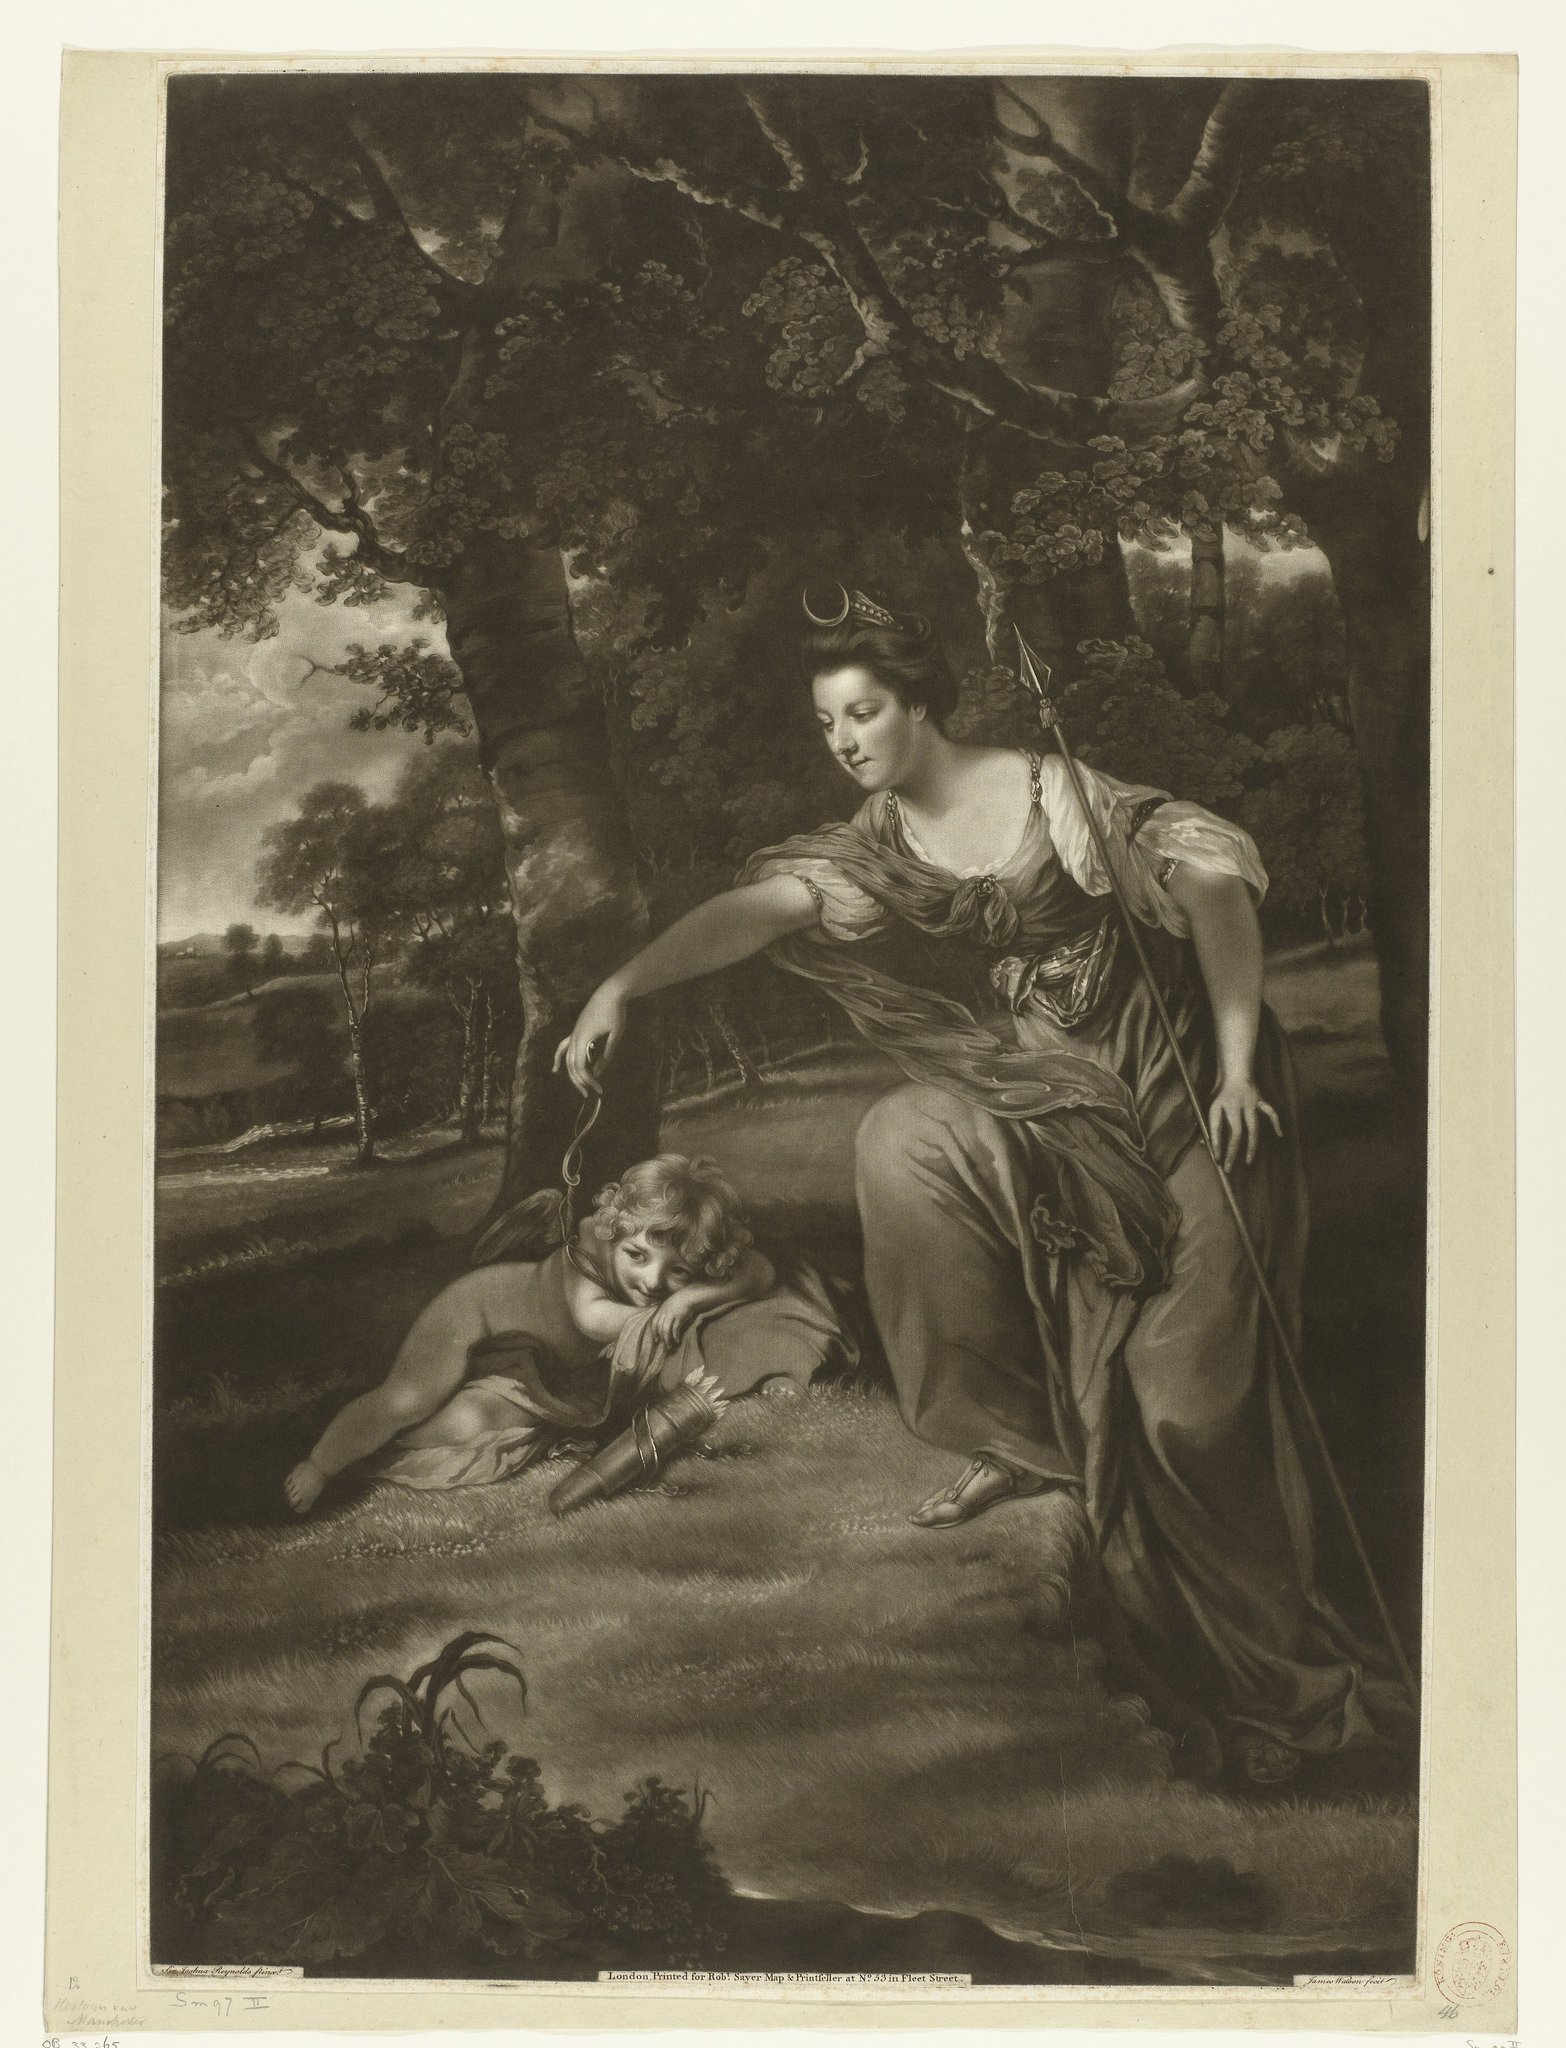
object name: print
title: Portret van Elizabeth Montagu en haar zoon George als Diana en Cupido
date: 1769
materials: paper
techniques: mezzotint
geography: london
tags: mother and son(s) (family group), (story of) diana (artemis), historical persons - bb - woman, historical persons, (story of) cupid, amor (eros)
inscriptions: collector's mark: Lugt 240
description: Elizabeth Montagu, als Diana, steelt de boog van haar zoon als Cupido.